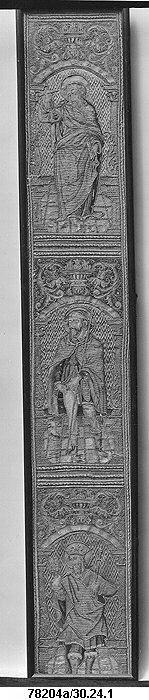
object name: orphrey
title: Orphrey (one of a pair)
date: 1501-1600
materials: canvas, metal thread, silk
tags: christ